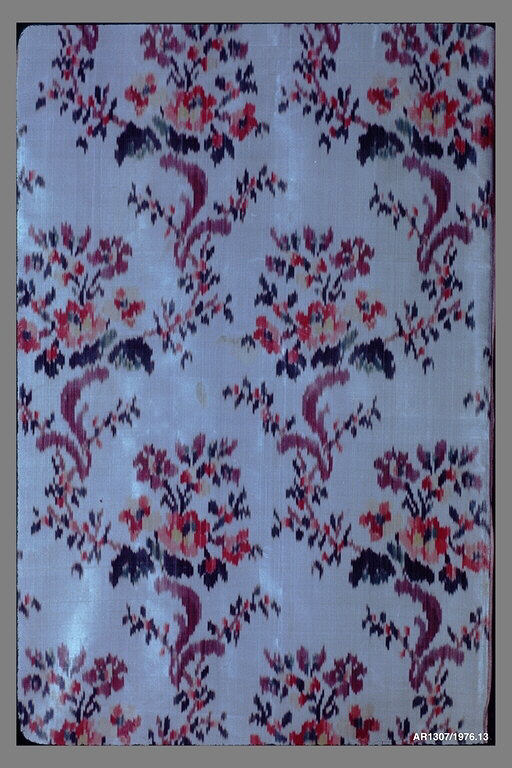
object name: panel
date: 1770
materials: silk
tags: flowers,leaves